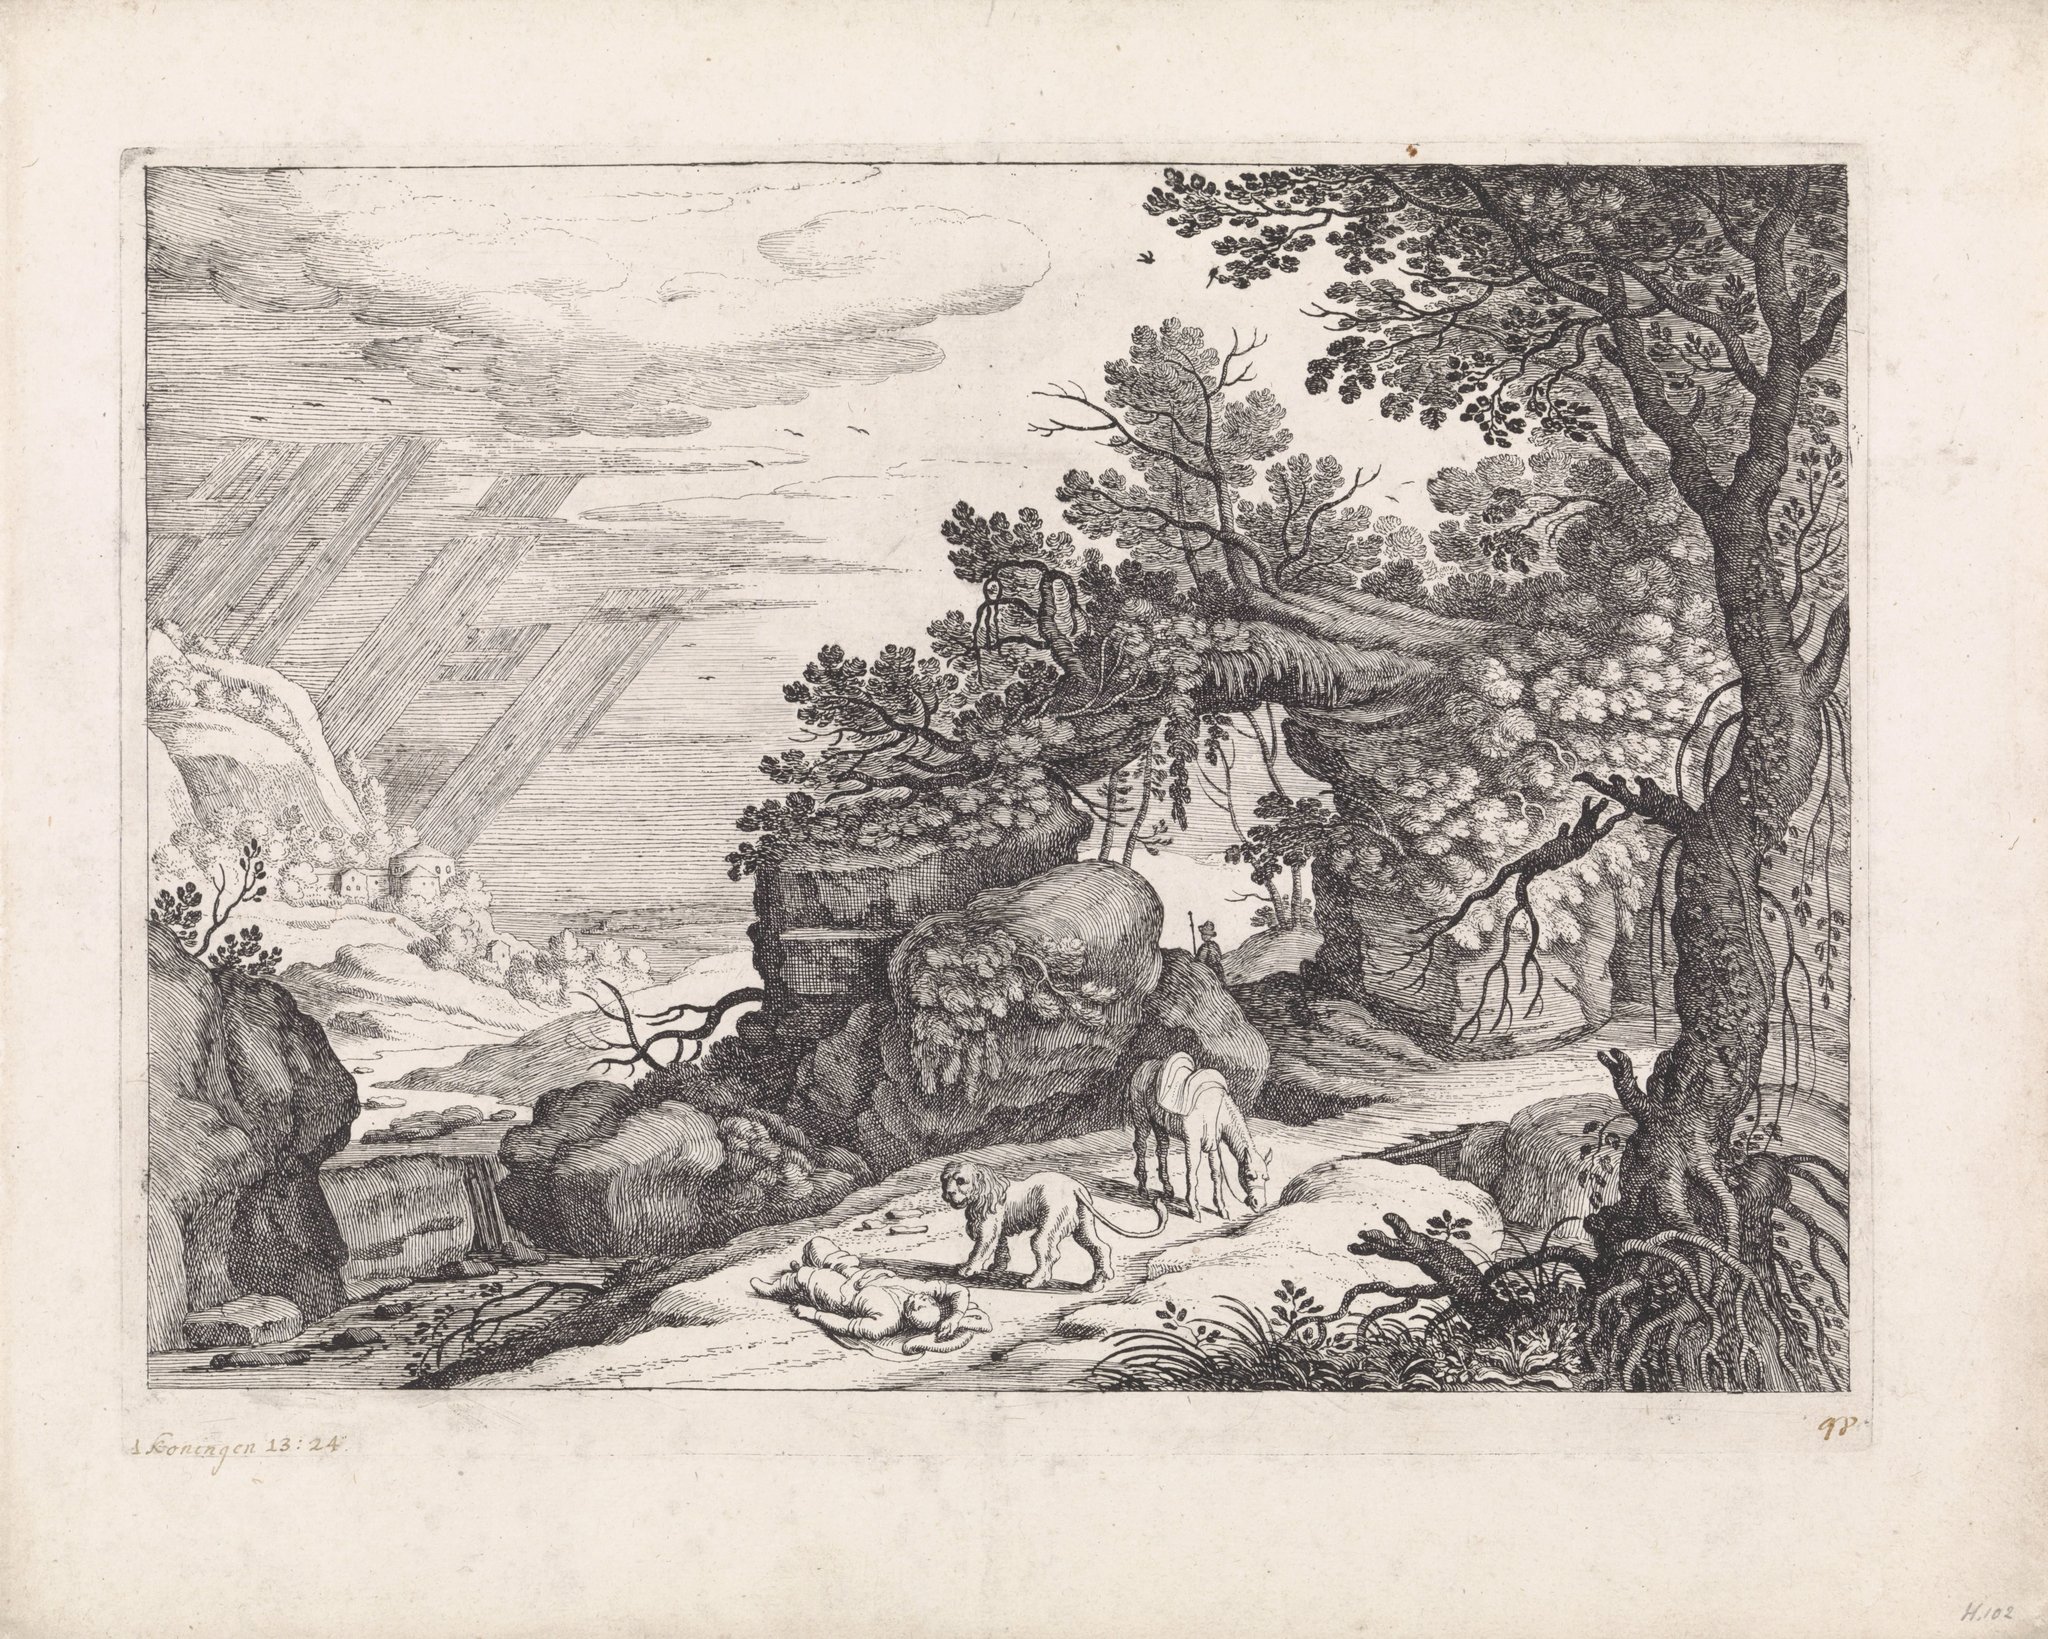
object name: print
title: Italiaanse landschappen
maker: guilliam van nieulandt (ii)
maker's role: draughtsman, print maker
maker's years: 1584-1635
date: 1594-1635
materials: paper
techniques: engraving, etching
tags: the body of the prophet of judah lies intact on the road with the donkey and the lion beside it, landscapes in the temperate zone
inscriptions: collector's mark: Lugt 2760, collector's mark: Lugt 2228, inscription: ‘1 Koningen 13: 24’, inscription: ‘98’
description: De gestorven godsman uit Juda op de weg. Naast hem staan de leeuw en de ezel. De godsman was tegen de opdracht van God in gegaan door toch in Betel te eten en te drinken. Toen hij daar vandaan ging werd hij door een leeuw aangevallen en gedood, maar niet verslonden. Naar het Bijbelverhaal uit 1 Kon. 13: 23-28. Prent uit een serie Italiaanse landschappen.